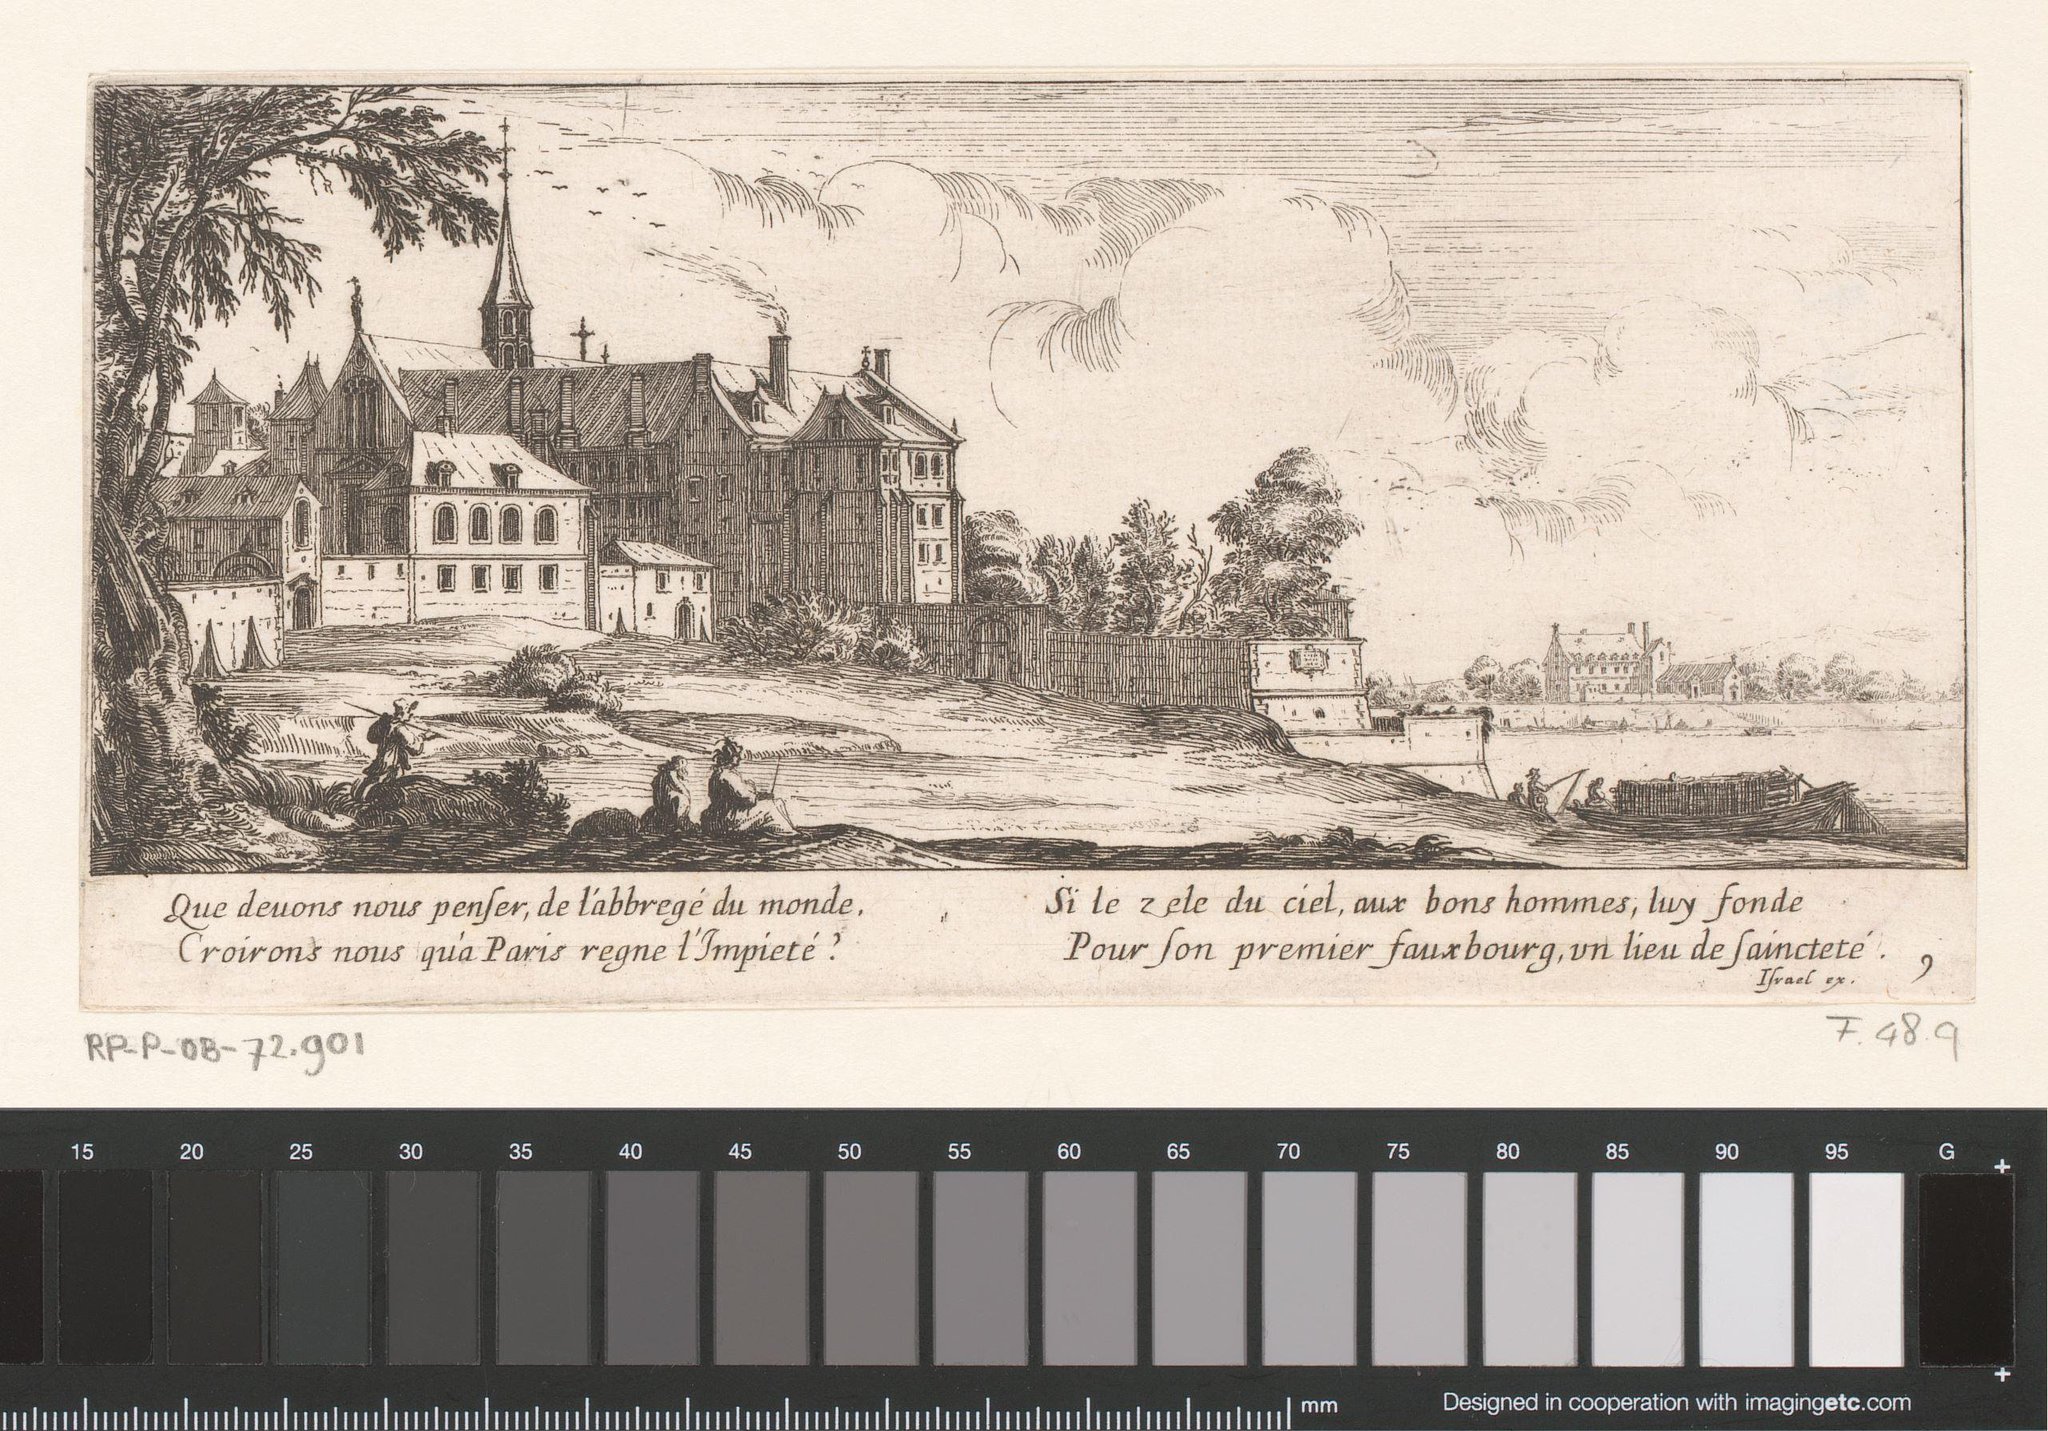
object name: print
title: Les lieux les plus remarquables de Paris et des environs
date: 1655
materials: paper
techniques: engraving, etching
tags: landscape with tower or castle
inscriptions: collector's mark: Lugt 240